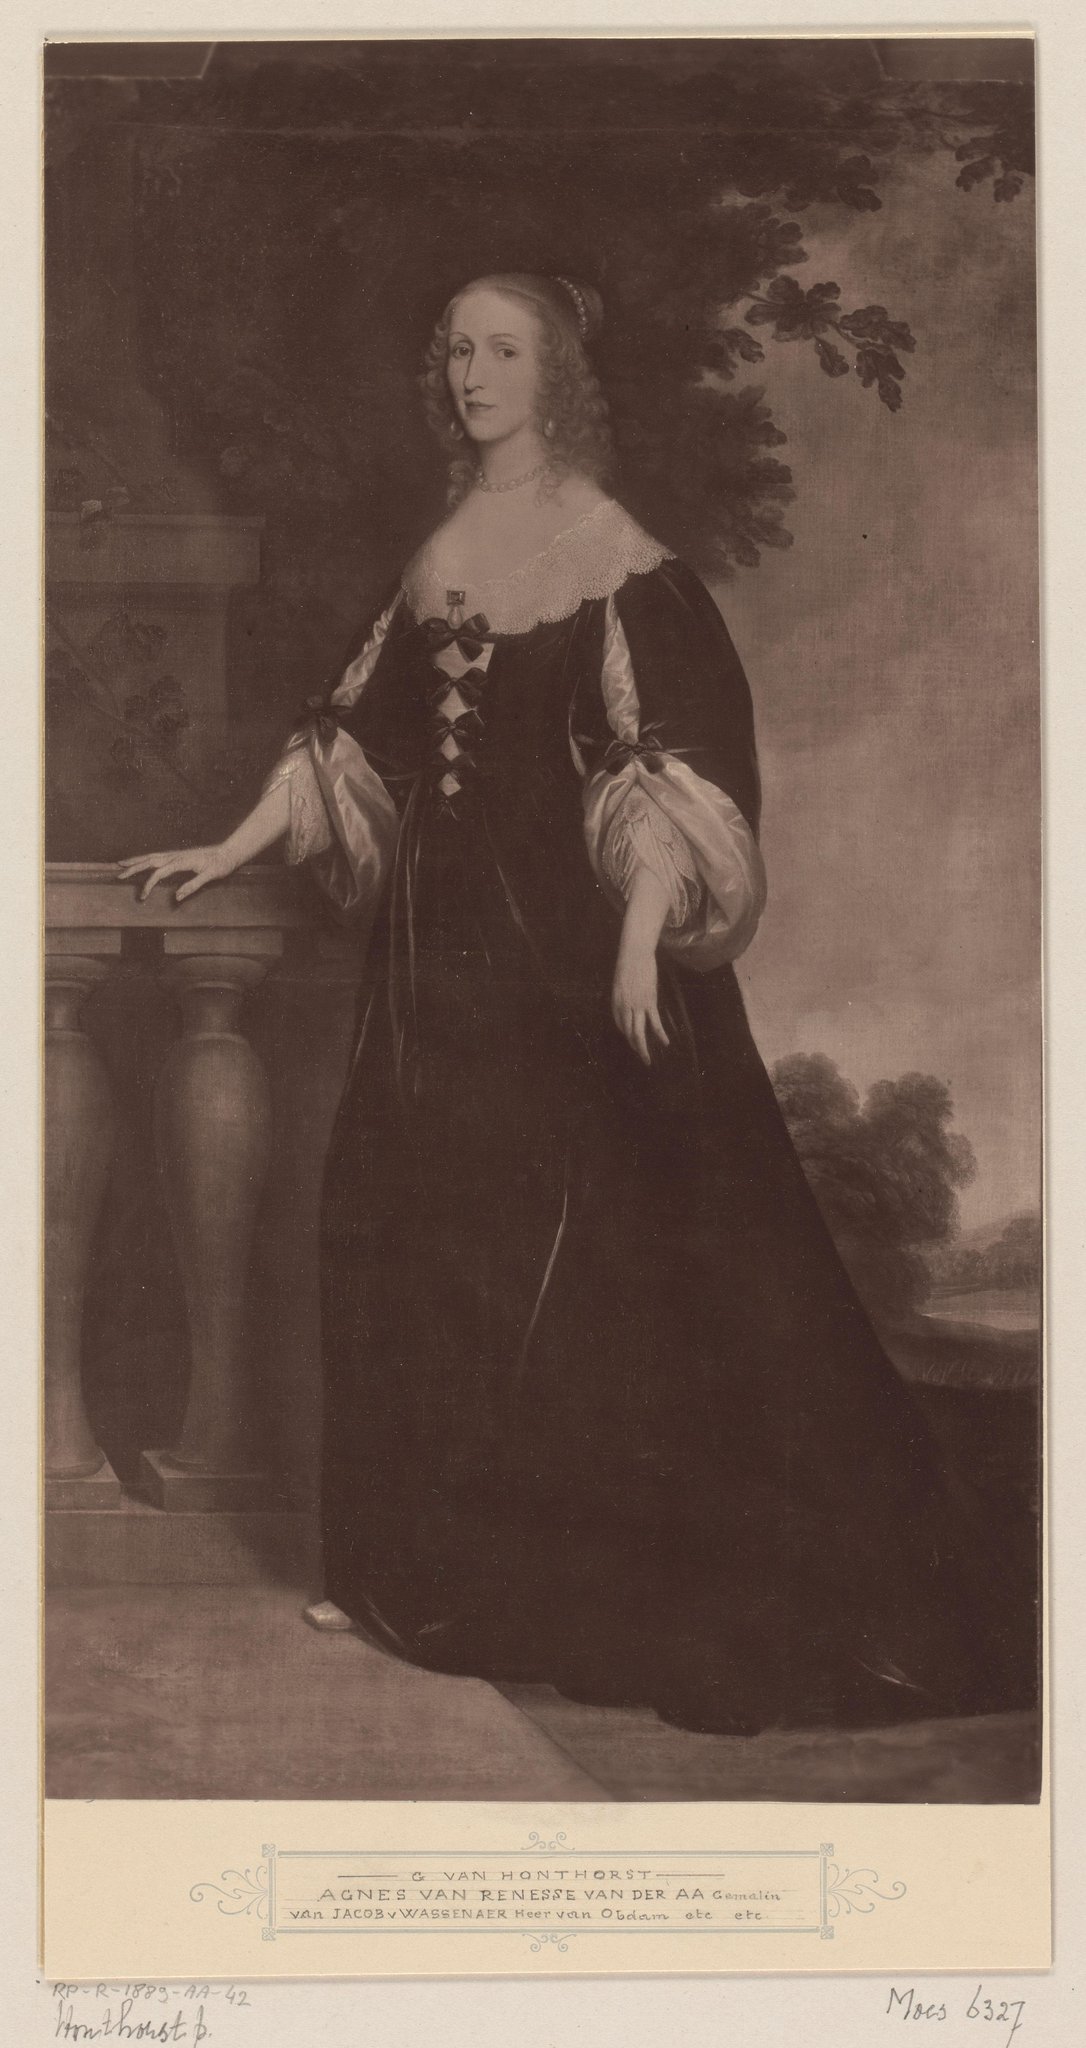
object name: photograph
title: Agnes van Renesse van der Aa, gemalin van Jacob v Wassenaer, heer van Obdam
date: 1880-1889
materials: cardboard, paper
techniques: collodion silver print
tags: historical persons - bb - woman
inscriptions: collector's mark: Lugt 2228